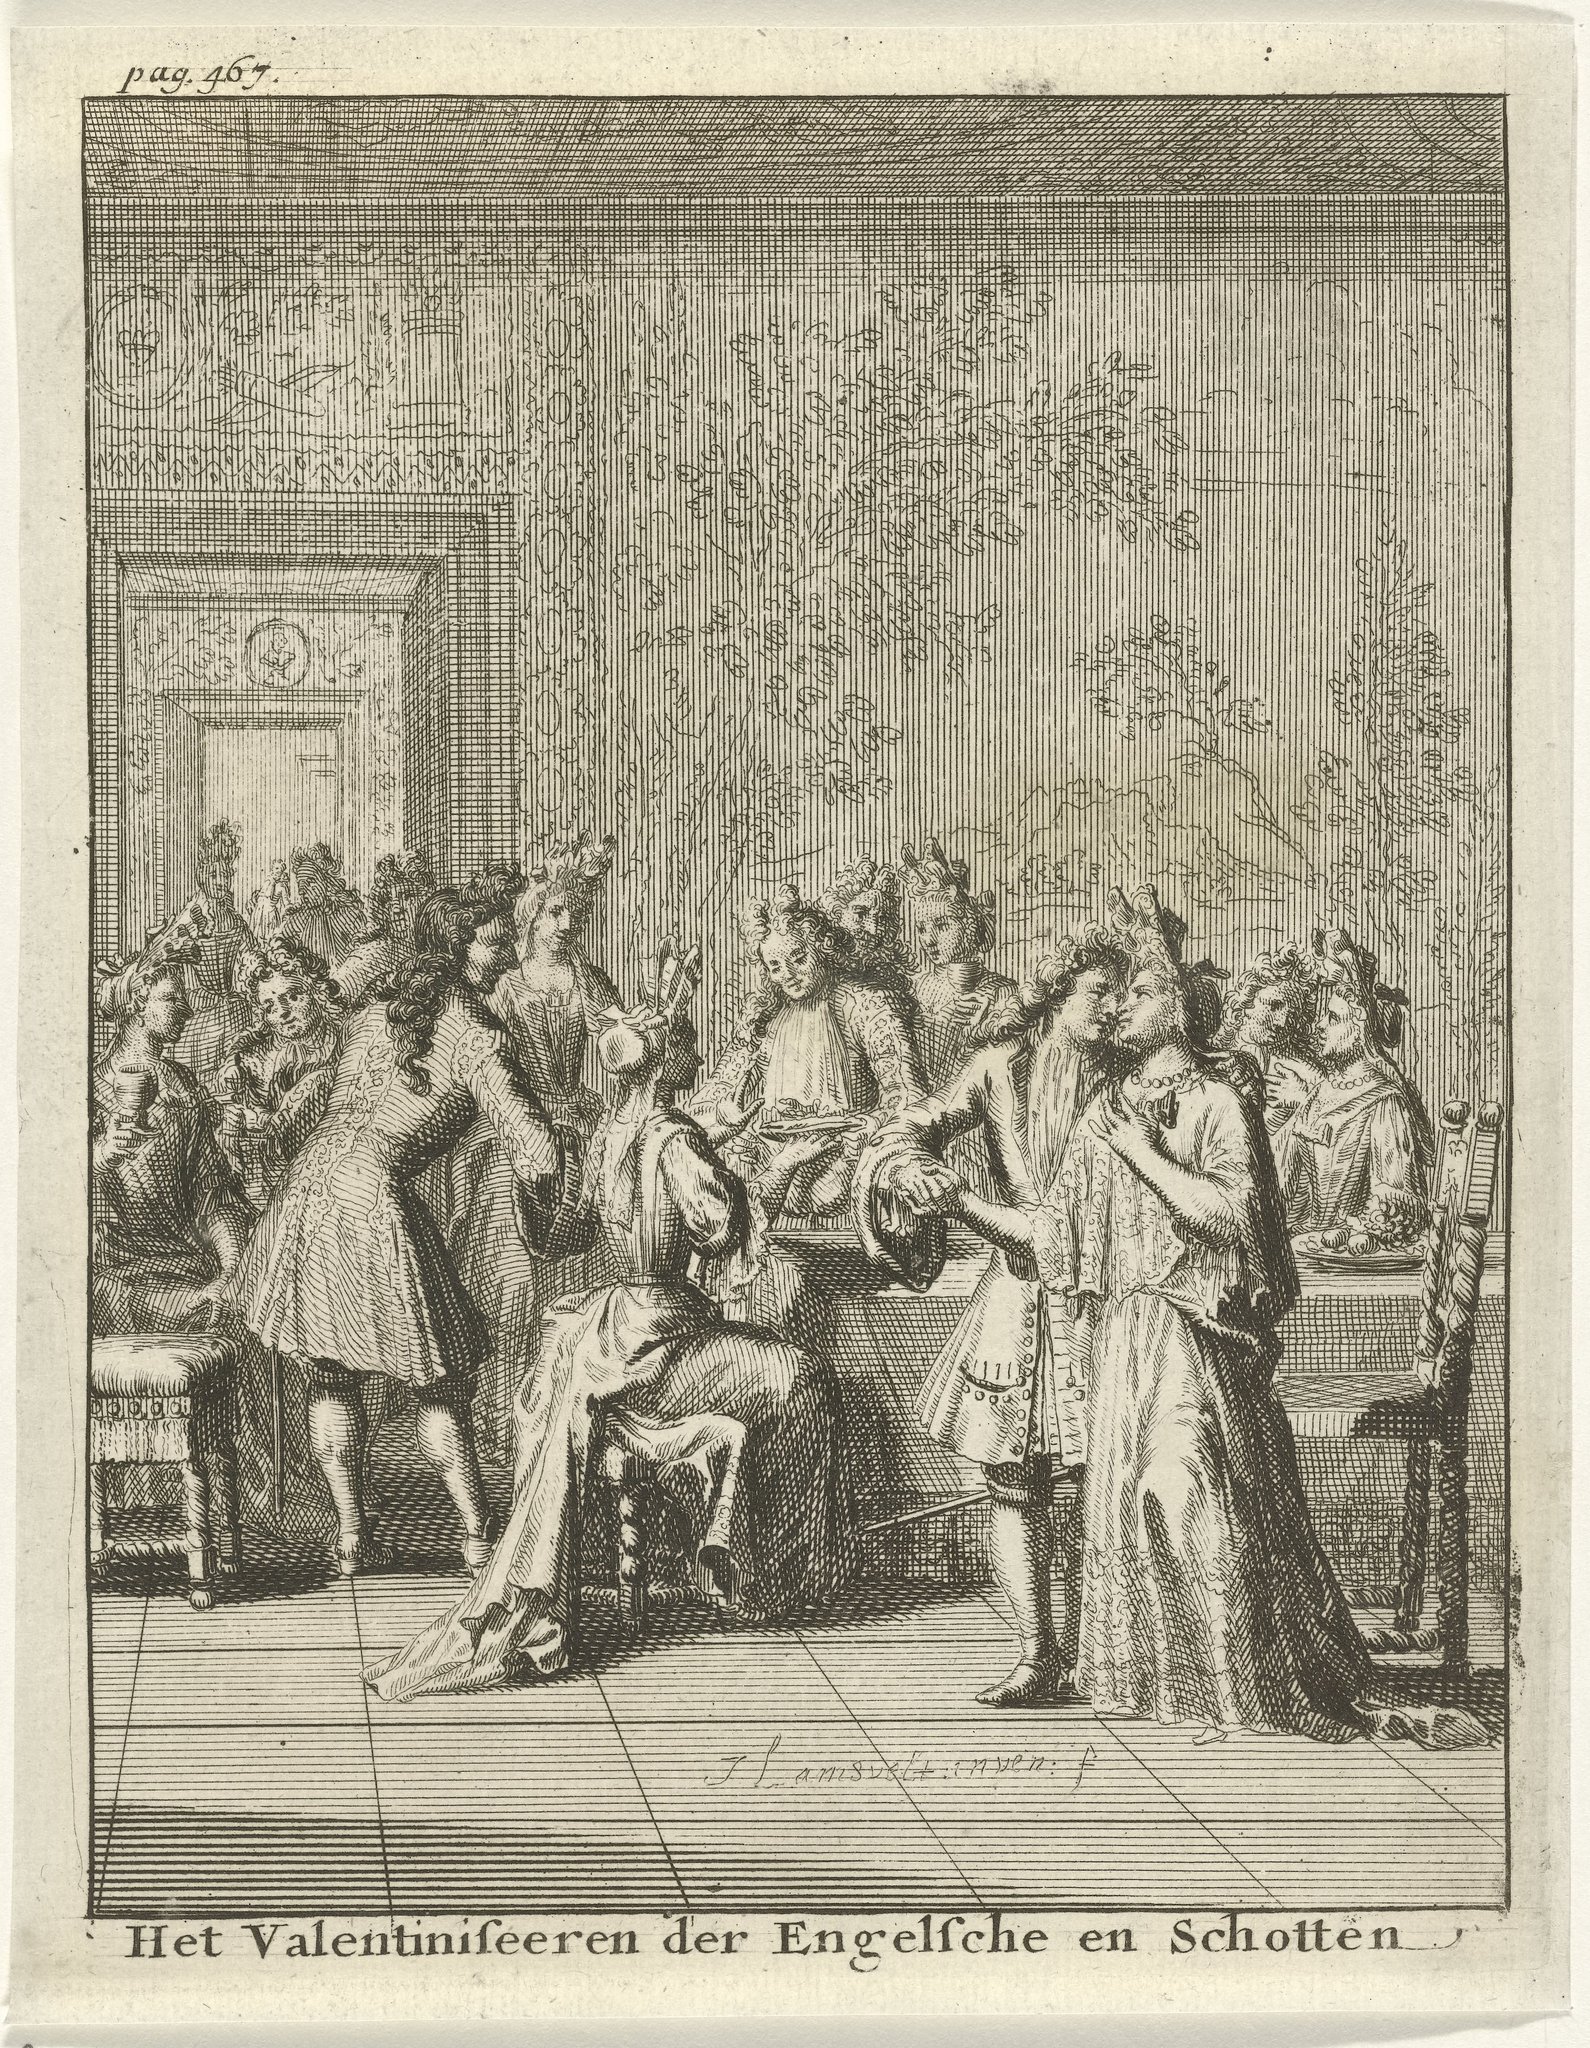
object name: print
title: Elegant gezelschap in een interieur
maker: jan lamsvelt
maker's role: print maker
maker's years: 1674-1743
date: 1700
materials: paper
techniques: etching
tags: visiting; receiving guests; elegant company, conversation, dialogue; conversation piece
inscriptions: collector's mark: Lugt 2228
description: Illustratie uit: Jordan de Colombier, Claude. Zeer gedenkwaardige en naaukeurige historische reis-beschrĳvinge, door Vrankrĳk, Spangie, Italien, Duitsland, Engeland, Holland, en Moscovien. Leiden: Boudewijn van der Aa (I), 1700.